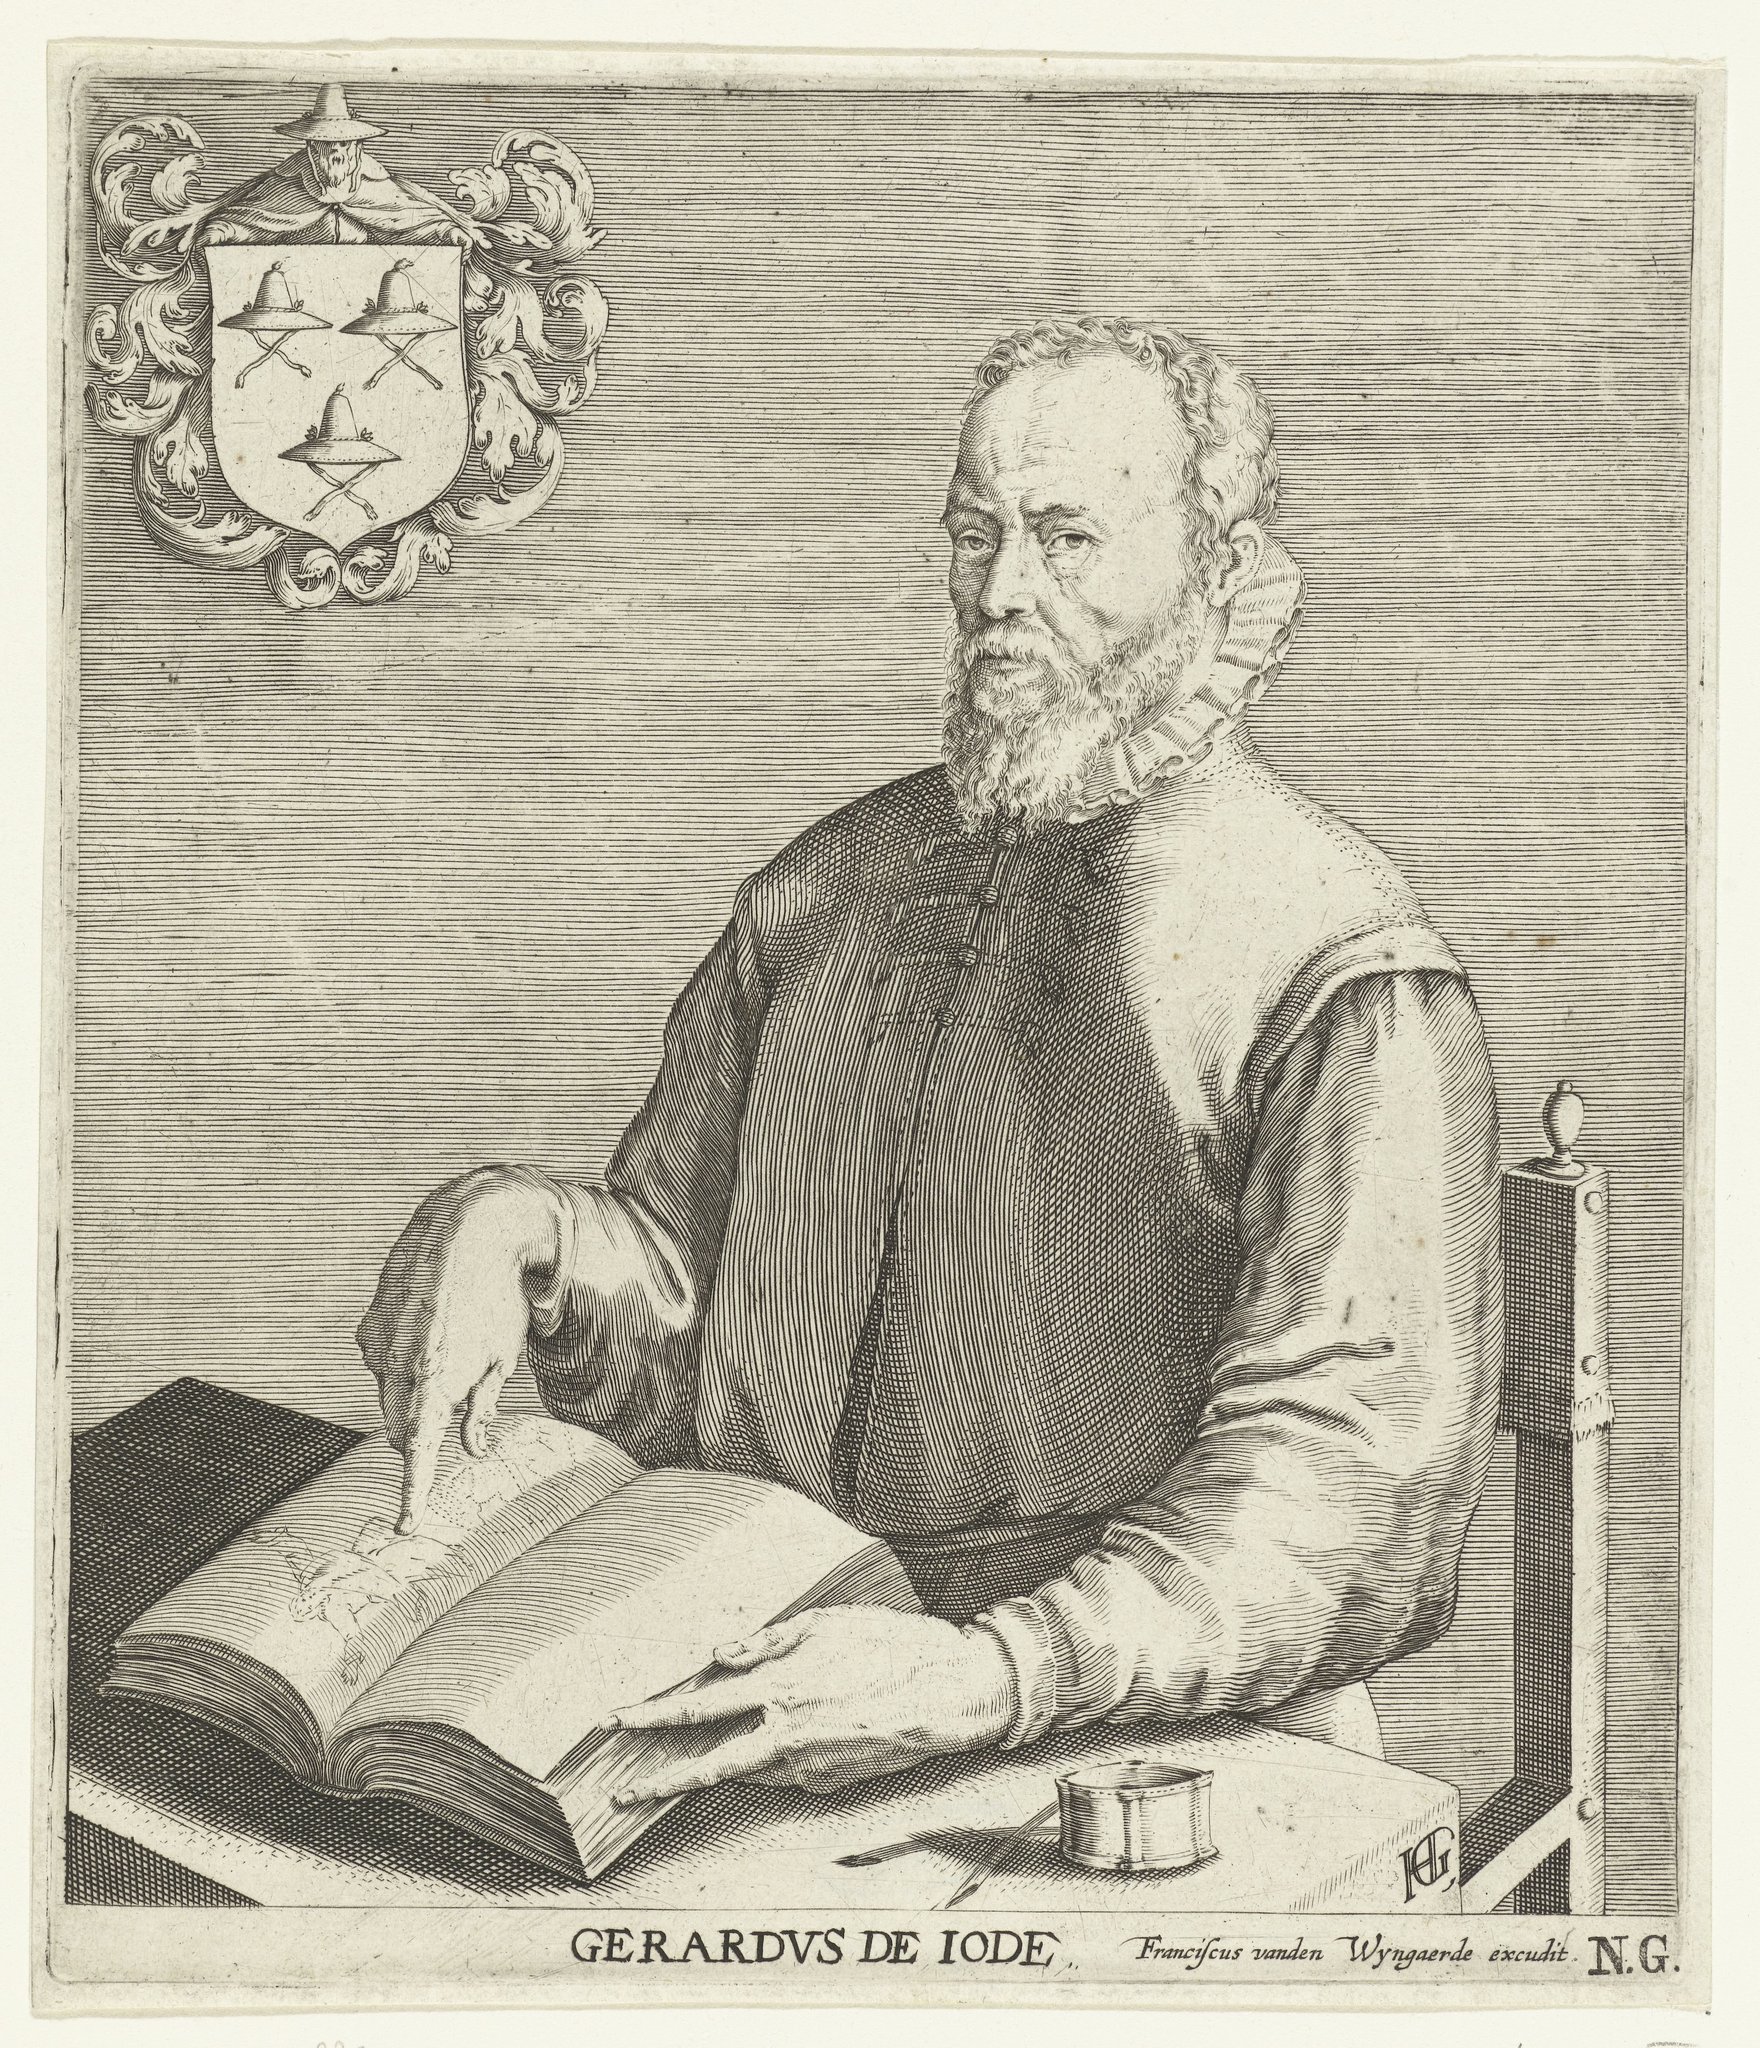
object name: print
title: Gerardus de Jode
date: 1624-1679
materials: paper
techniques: engraving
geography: low countries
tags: nijmegen, antwerp, print maker, draughtsman, publisher, gerard de jode, historical persons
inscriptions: collector's mark: Lugt 1967, collector's mark: Lugt 2228a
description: Portret van een man, ten halven lijve, zitten aan een tafel, wijzend in een boek. Linksboven een wapen. In de marge onder de voorstelling de naam van de geprotretteerde.